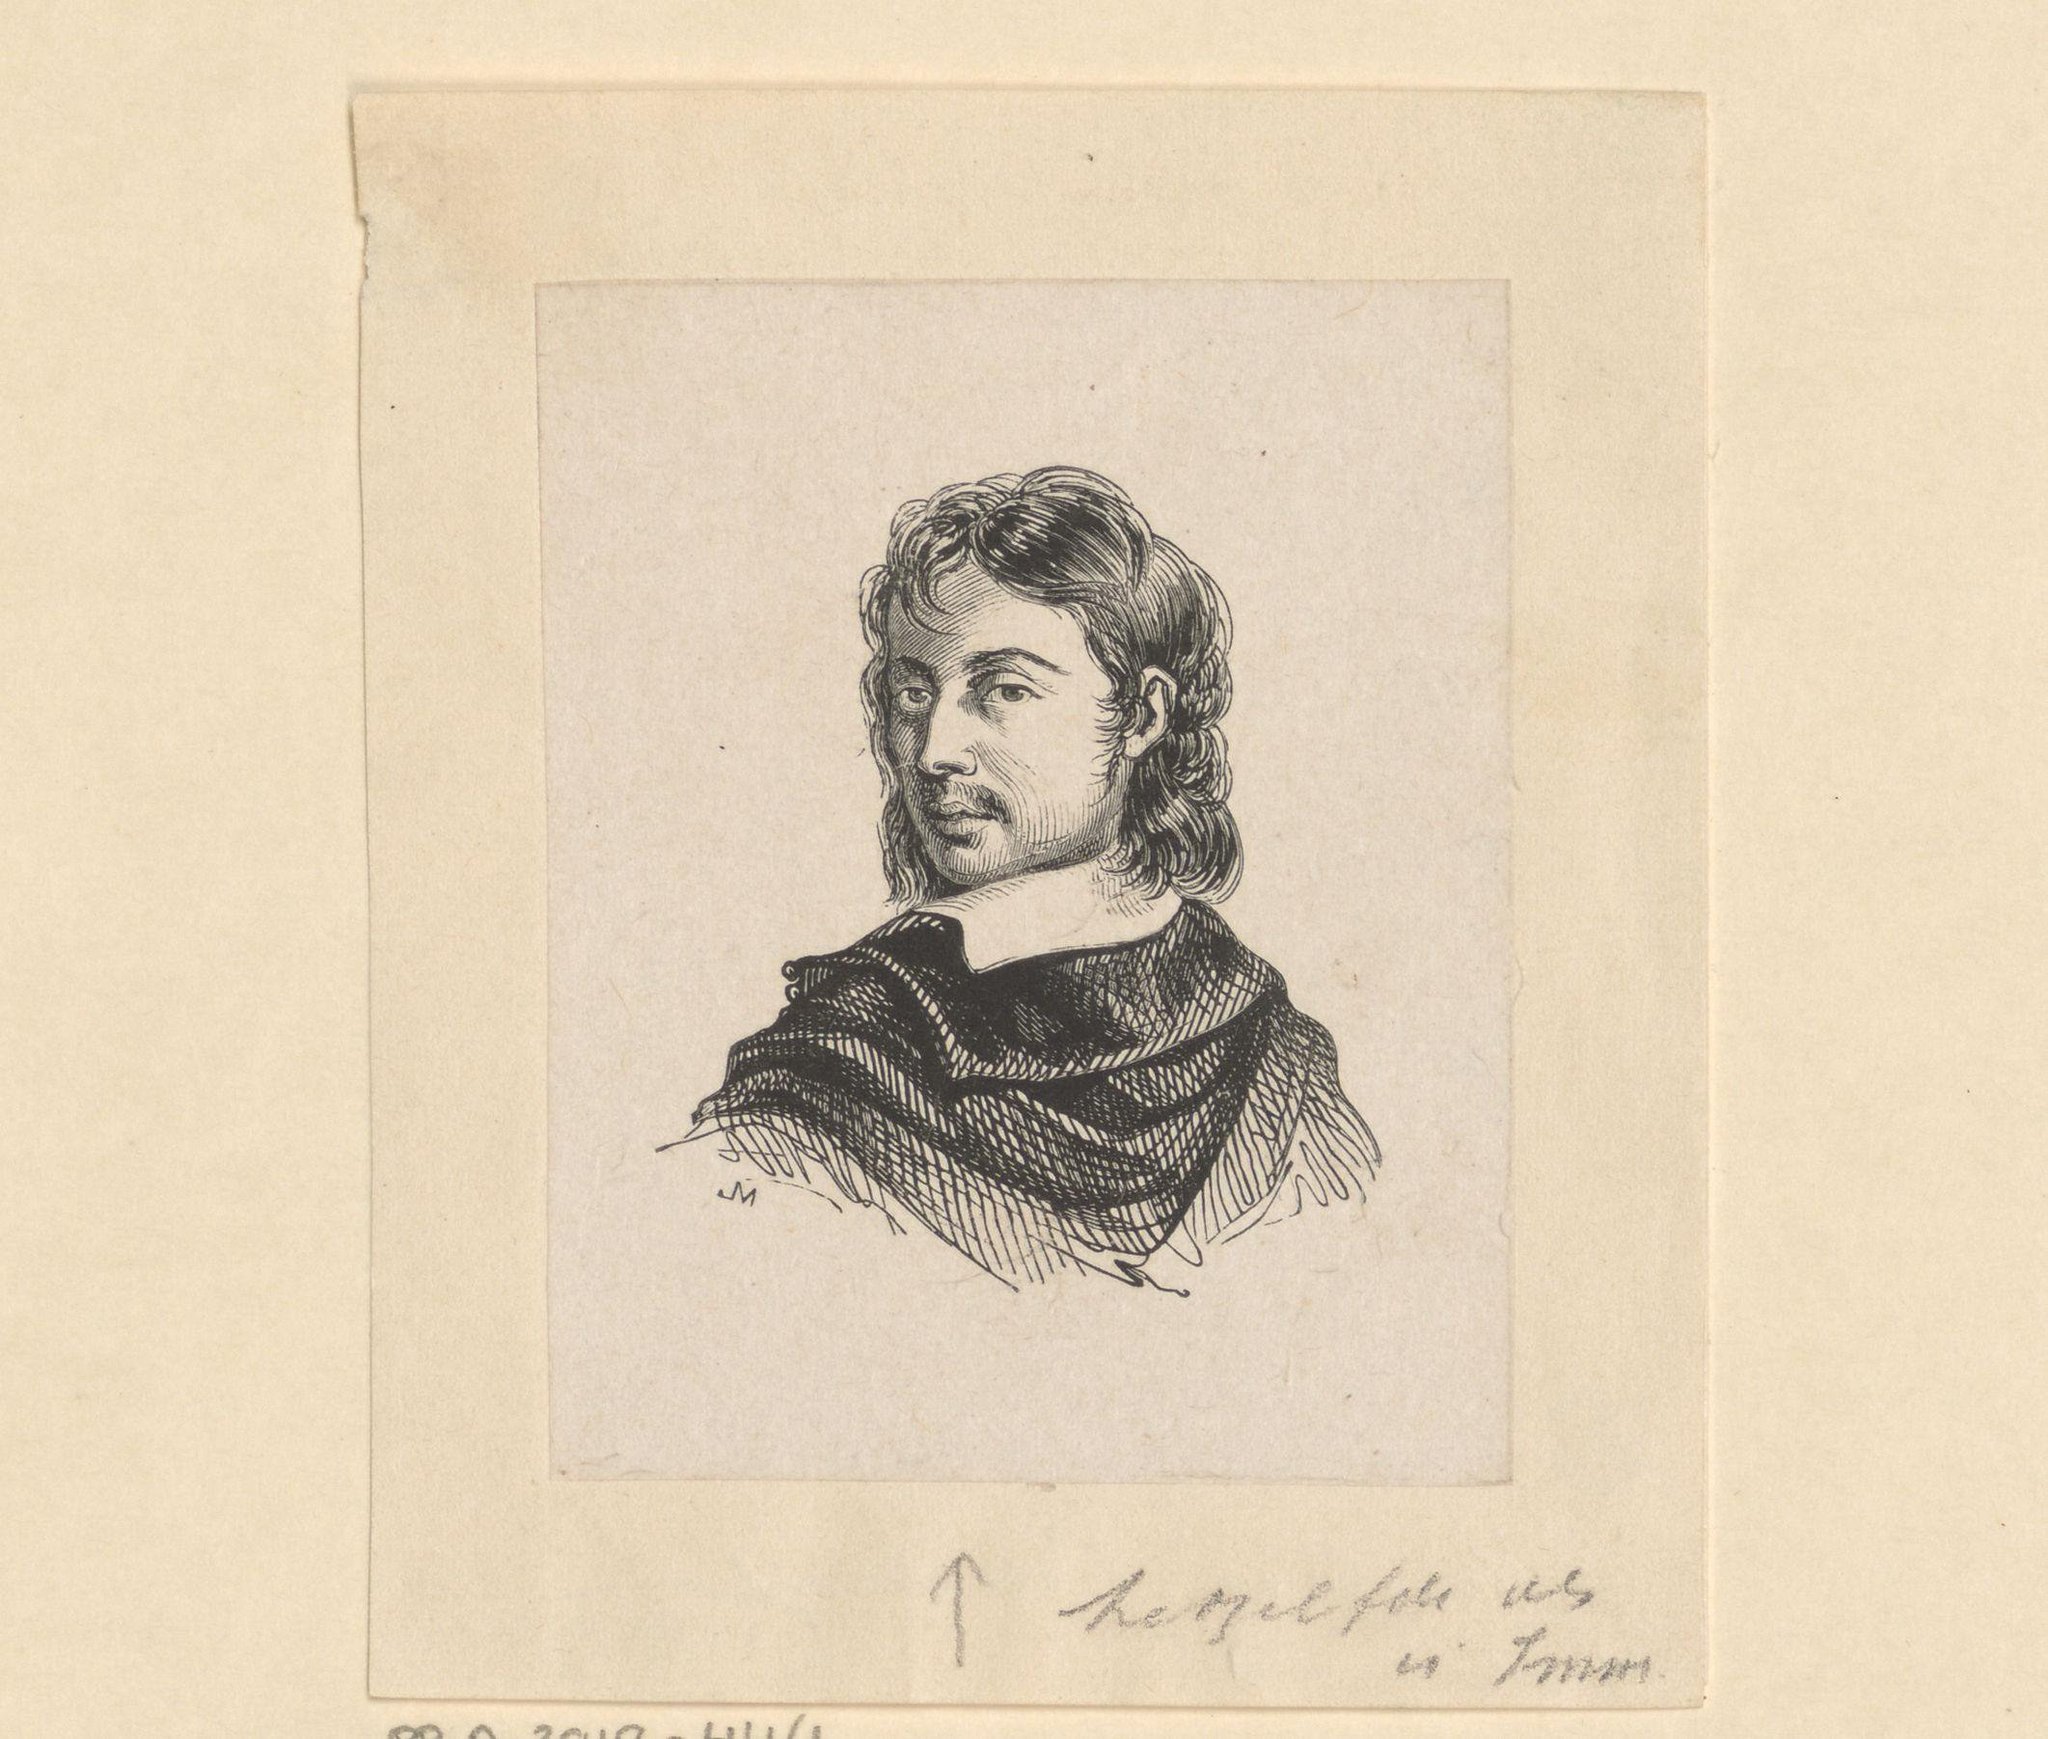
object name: print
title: Portret van Nicolaes Berchem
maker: monogrammist jm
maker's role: draughtsman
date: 1842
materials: paper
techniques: engraving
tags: haarlem, amsterdam, print maker, draughtsman, nicolaes pietersz berchem, historical persons, portrait, self-portrait of painter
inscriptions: collector's mark: Lugt 2760, collector's mark: Lugt 2228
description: Prent met tekst op verso gebruikt in: Immerzeel, Johannes. De levens en werken der Hollandsche en Vlaamsche kunstschilders (...). Amsterdam: Christiaan Lodewijk van Kesteren, 1842, dl. 1, p. 41.